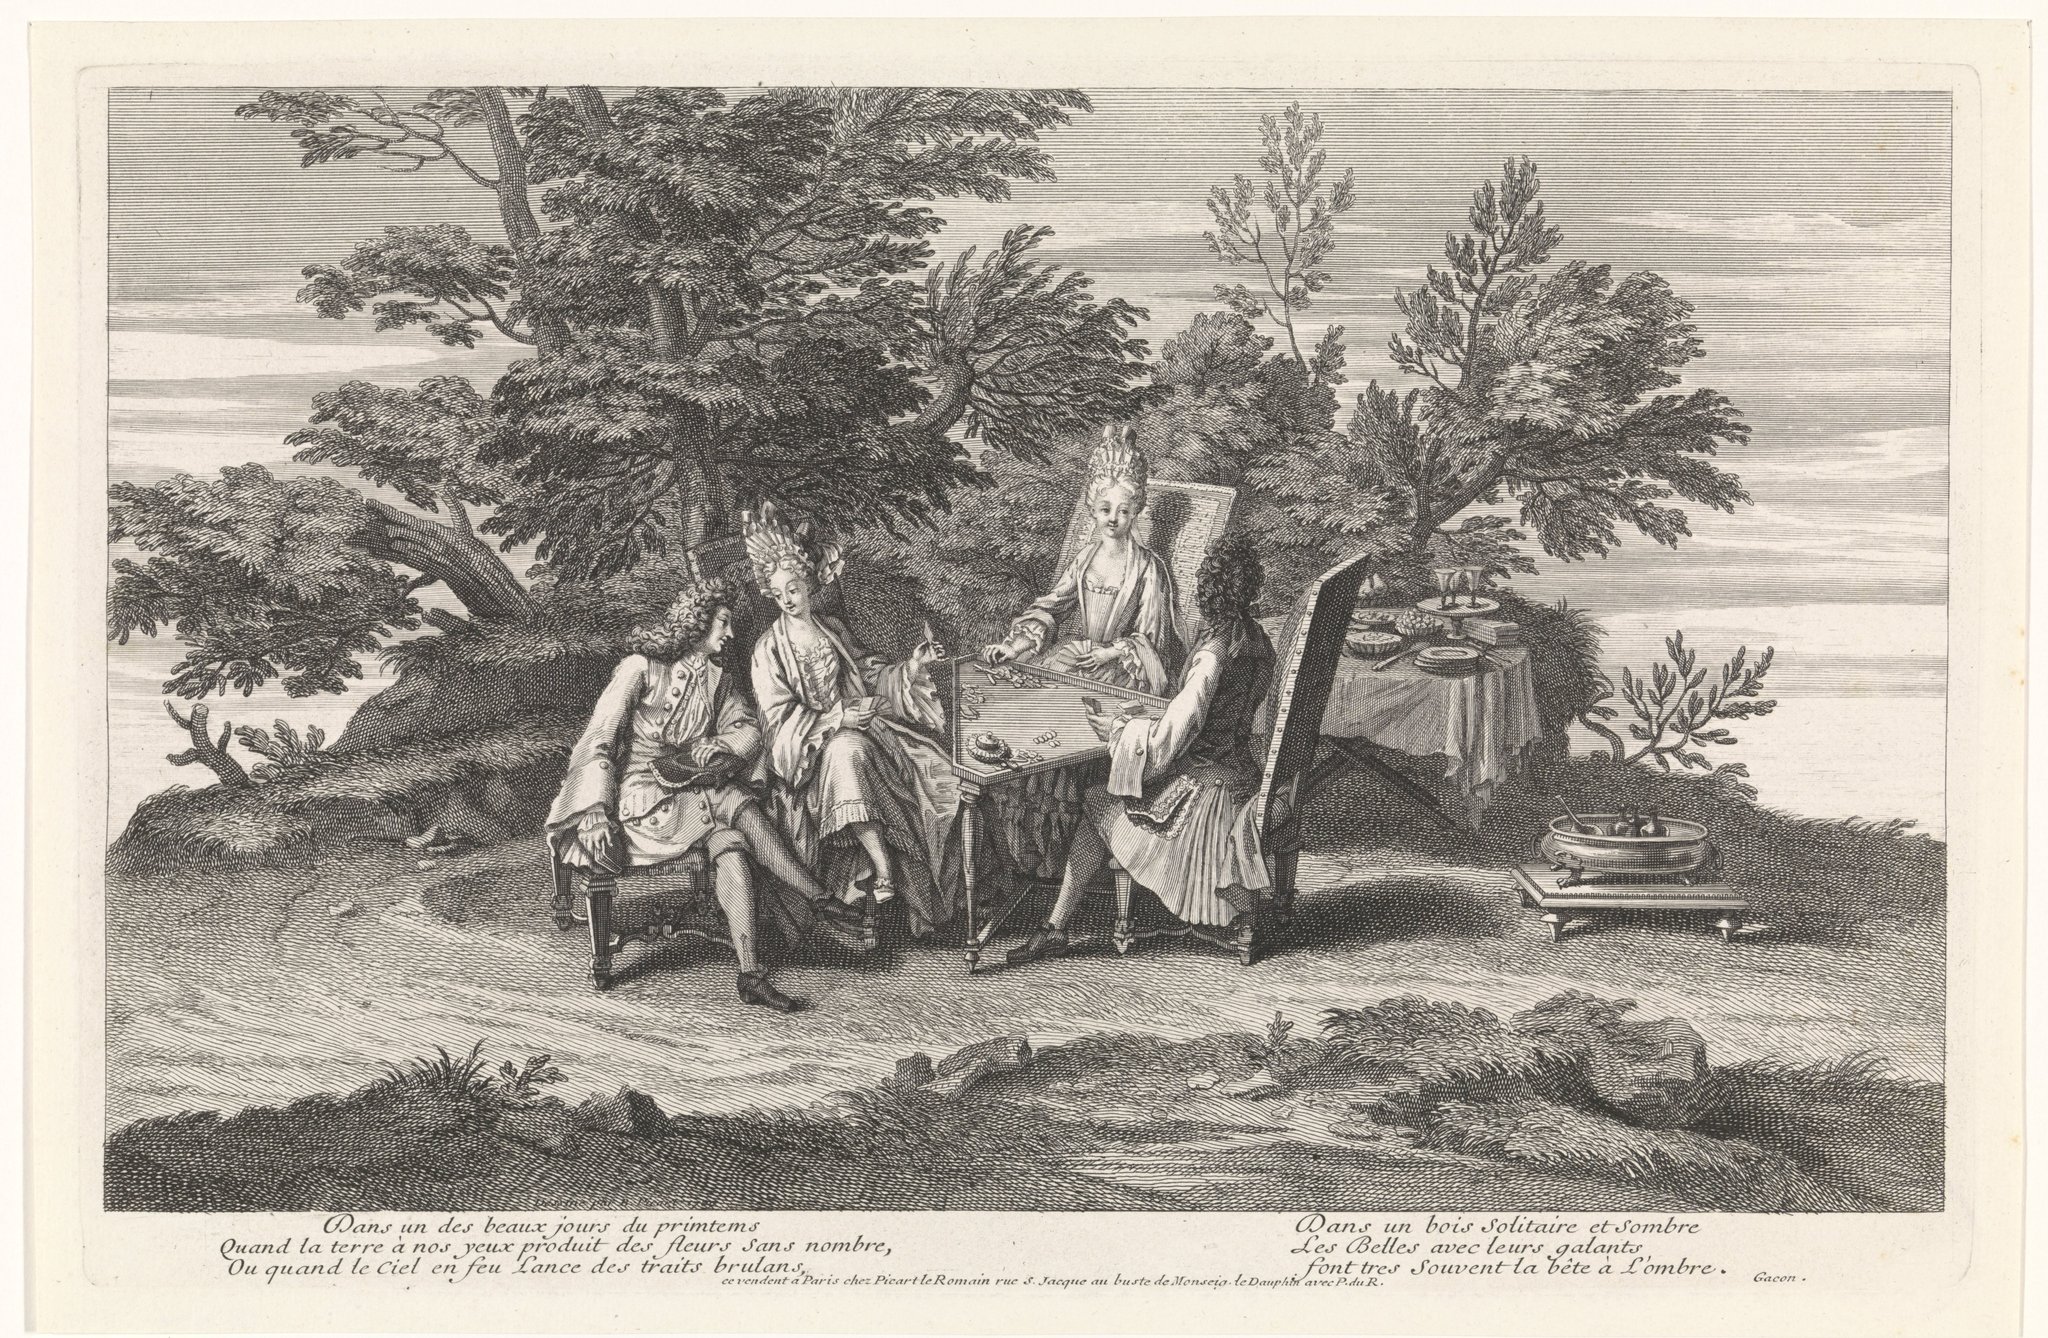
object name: print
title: Elegant gezelschap speelt het kaartspel Jeu de l'hombre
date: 1709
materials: paper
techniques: engraving, etching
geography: paris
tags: card games, party games with erotic implications, e.g.: kissing contest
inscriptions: collector's mark: Lugt 240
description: Een gezelschap van twee mannen en twee vrouwen speelt het kaartspel Jeu de l'hombre aan een driehoekige tafel in een park. In dit spel wordt degene die een kaart vraagt "hombre" genoemd. In de marge een zesregelig gedicht, in twee kolommen, in het Frans.